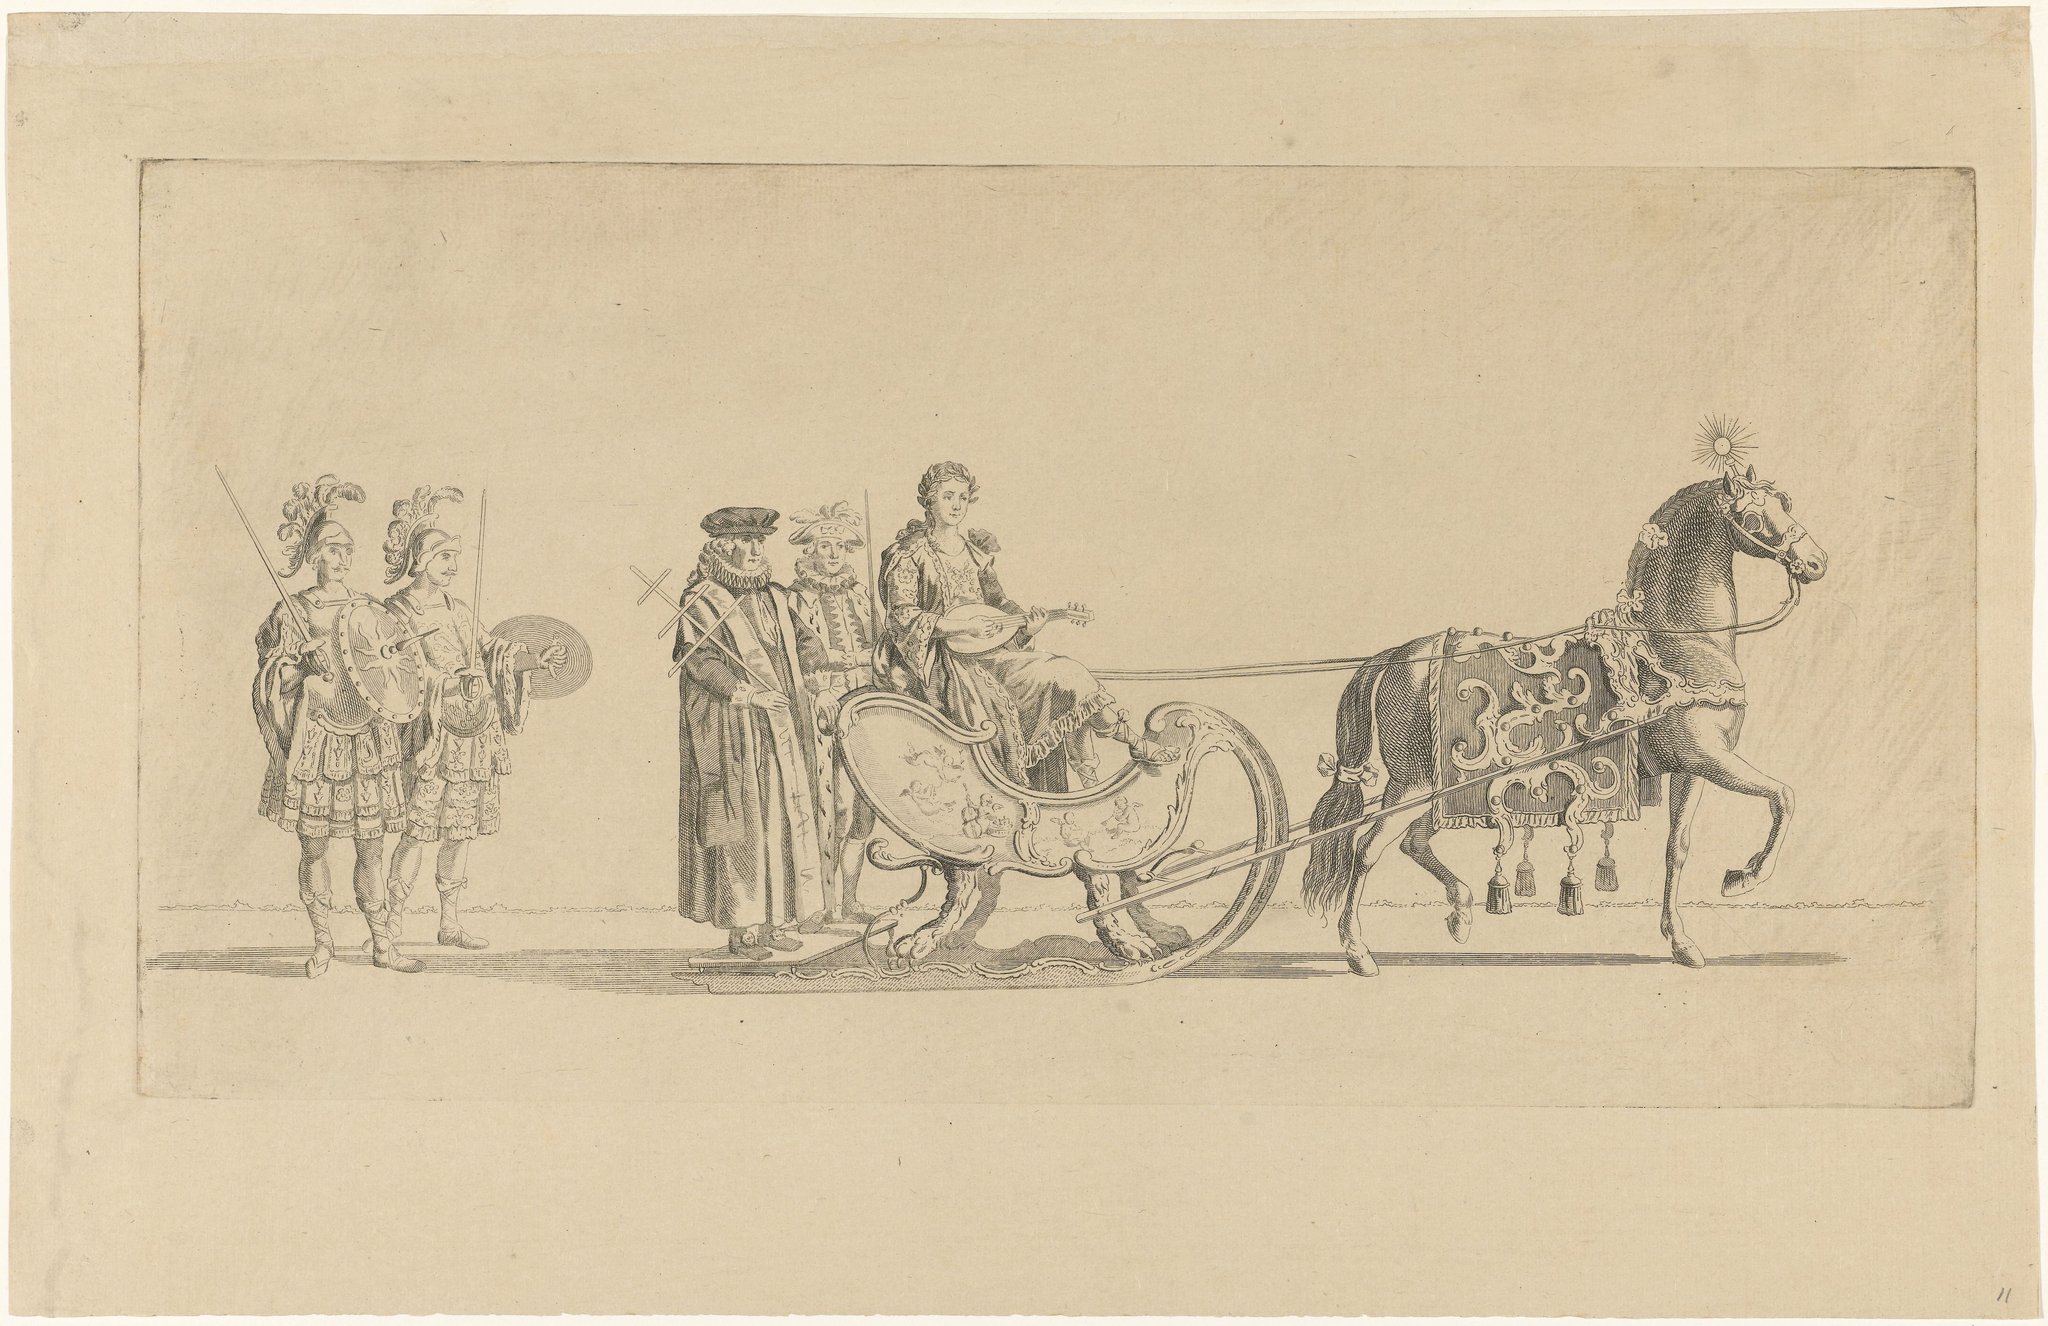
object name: print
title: Elfde slede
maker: nicolaas van der worm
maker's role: draughtsman, print maker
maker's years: 1757-1828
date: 1776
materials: paper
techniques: etching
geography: northern netherlands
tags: sledge, sleigh (winter sports), commemoration of the founding of a university, leiden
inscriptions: collector's mark: Lugt 240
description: De elfde slede in de optocht. Een slede met de personificatie van de Muziek, getrokken door een paard, gevolgd door twee Romeinse soldaten. Onderdeel van een reeks van twaalf platen (etsdruk vóór het nummer en op ander papier) van de sledevaart op 24 januari 1776 georganiseerd door het Leidse genootschap Veniam Pro Laude bij gelegenheid van het Tweede Eeuwfeest van het Leids Ontzet (3 oktober 1574) en de oprichting van de Universiteit van Leiden (8 februari 1575).